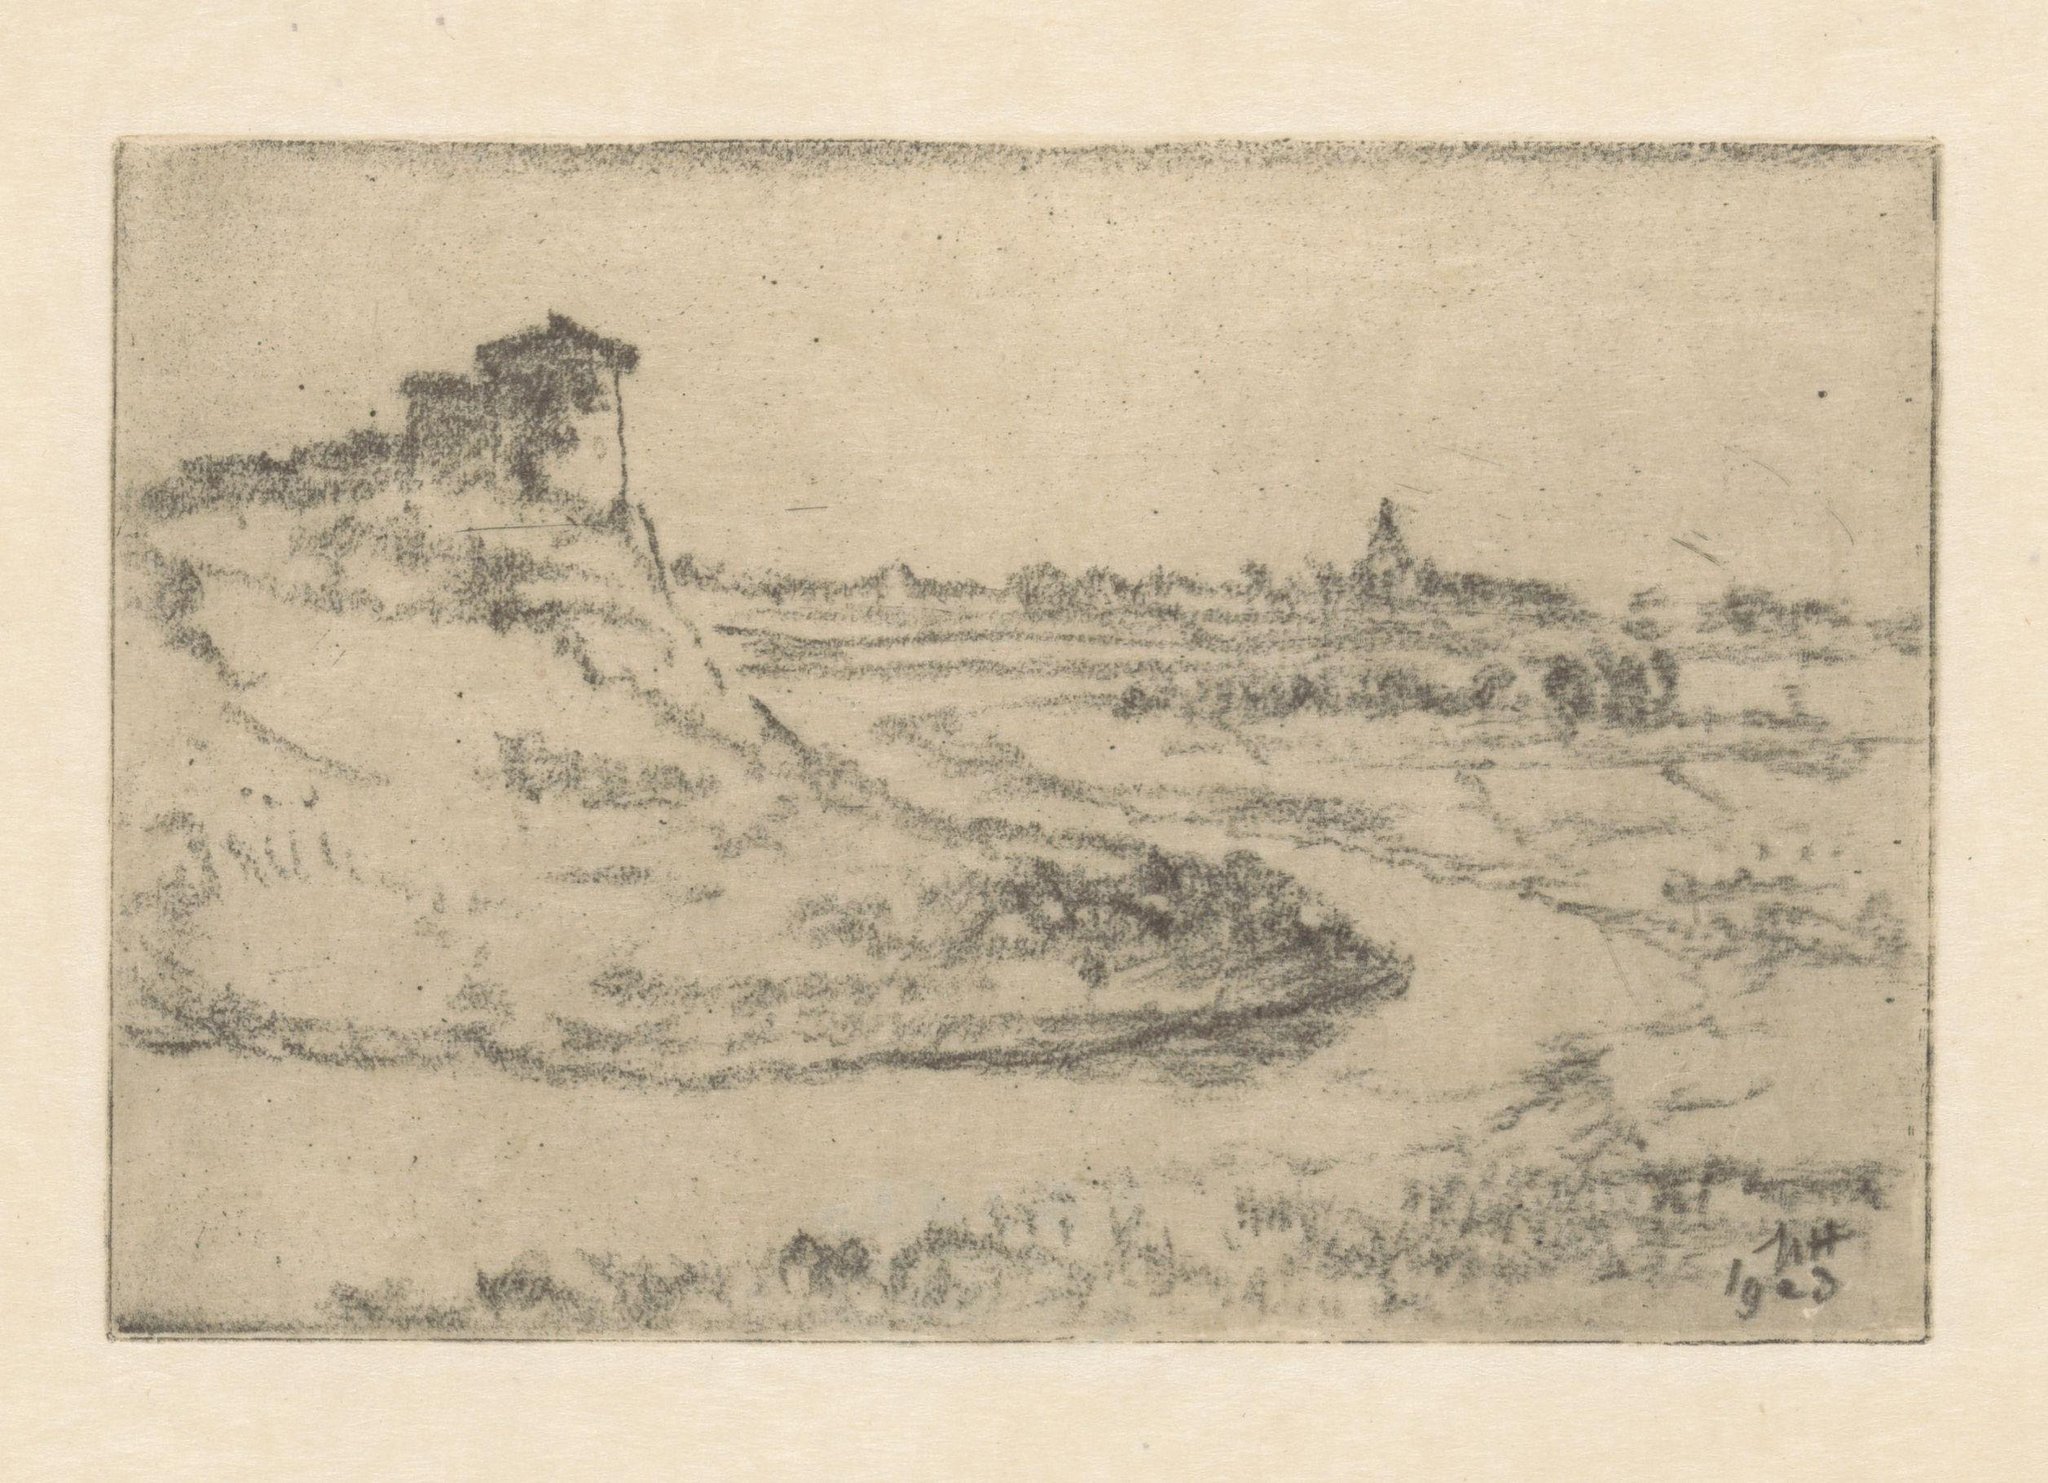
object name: print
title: Rivierlandschap met heuvel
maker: marius holleman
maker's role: draughtsman, print maker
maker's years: 1878-1926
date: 1923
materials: paper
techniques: etching, intaglio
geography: groningen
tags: low hill country, river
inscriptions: collector's mark: Lugt 2228